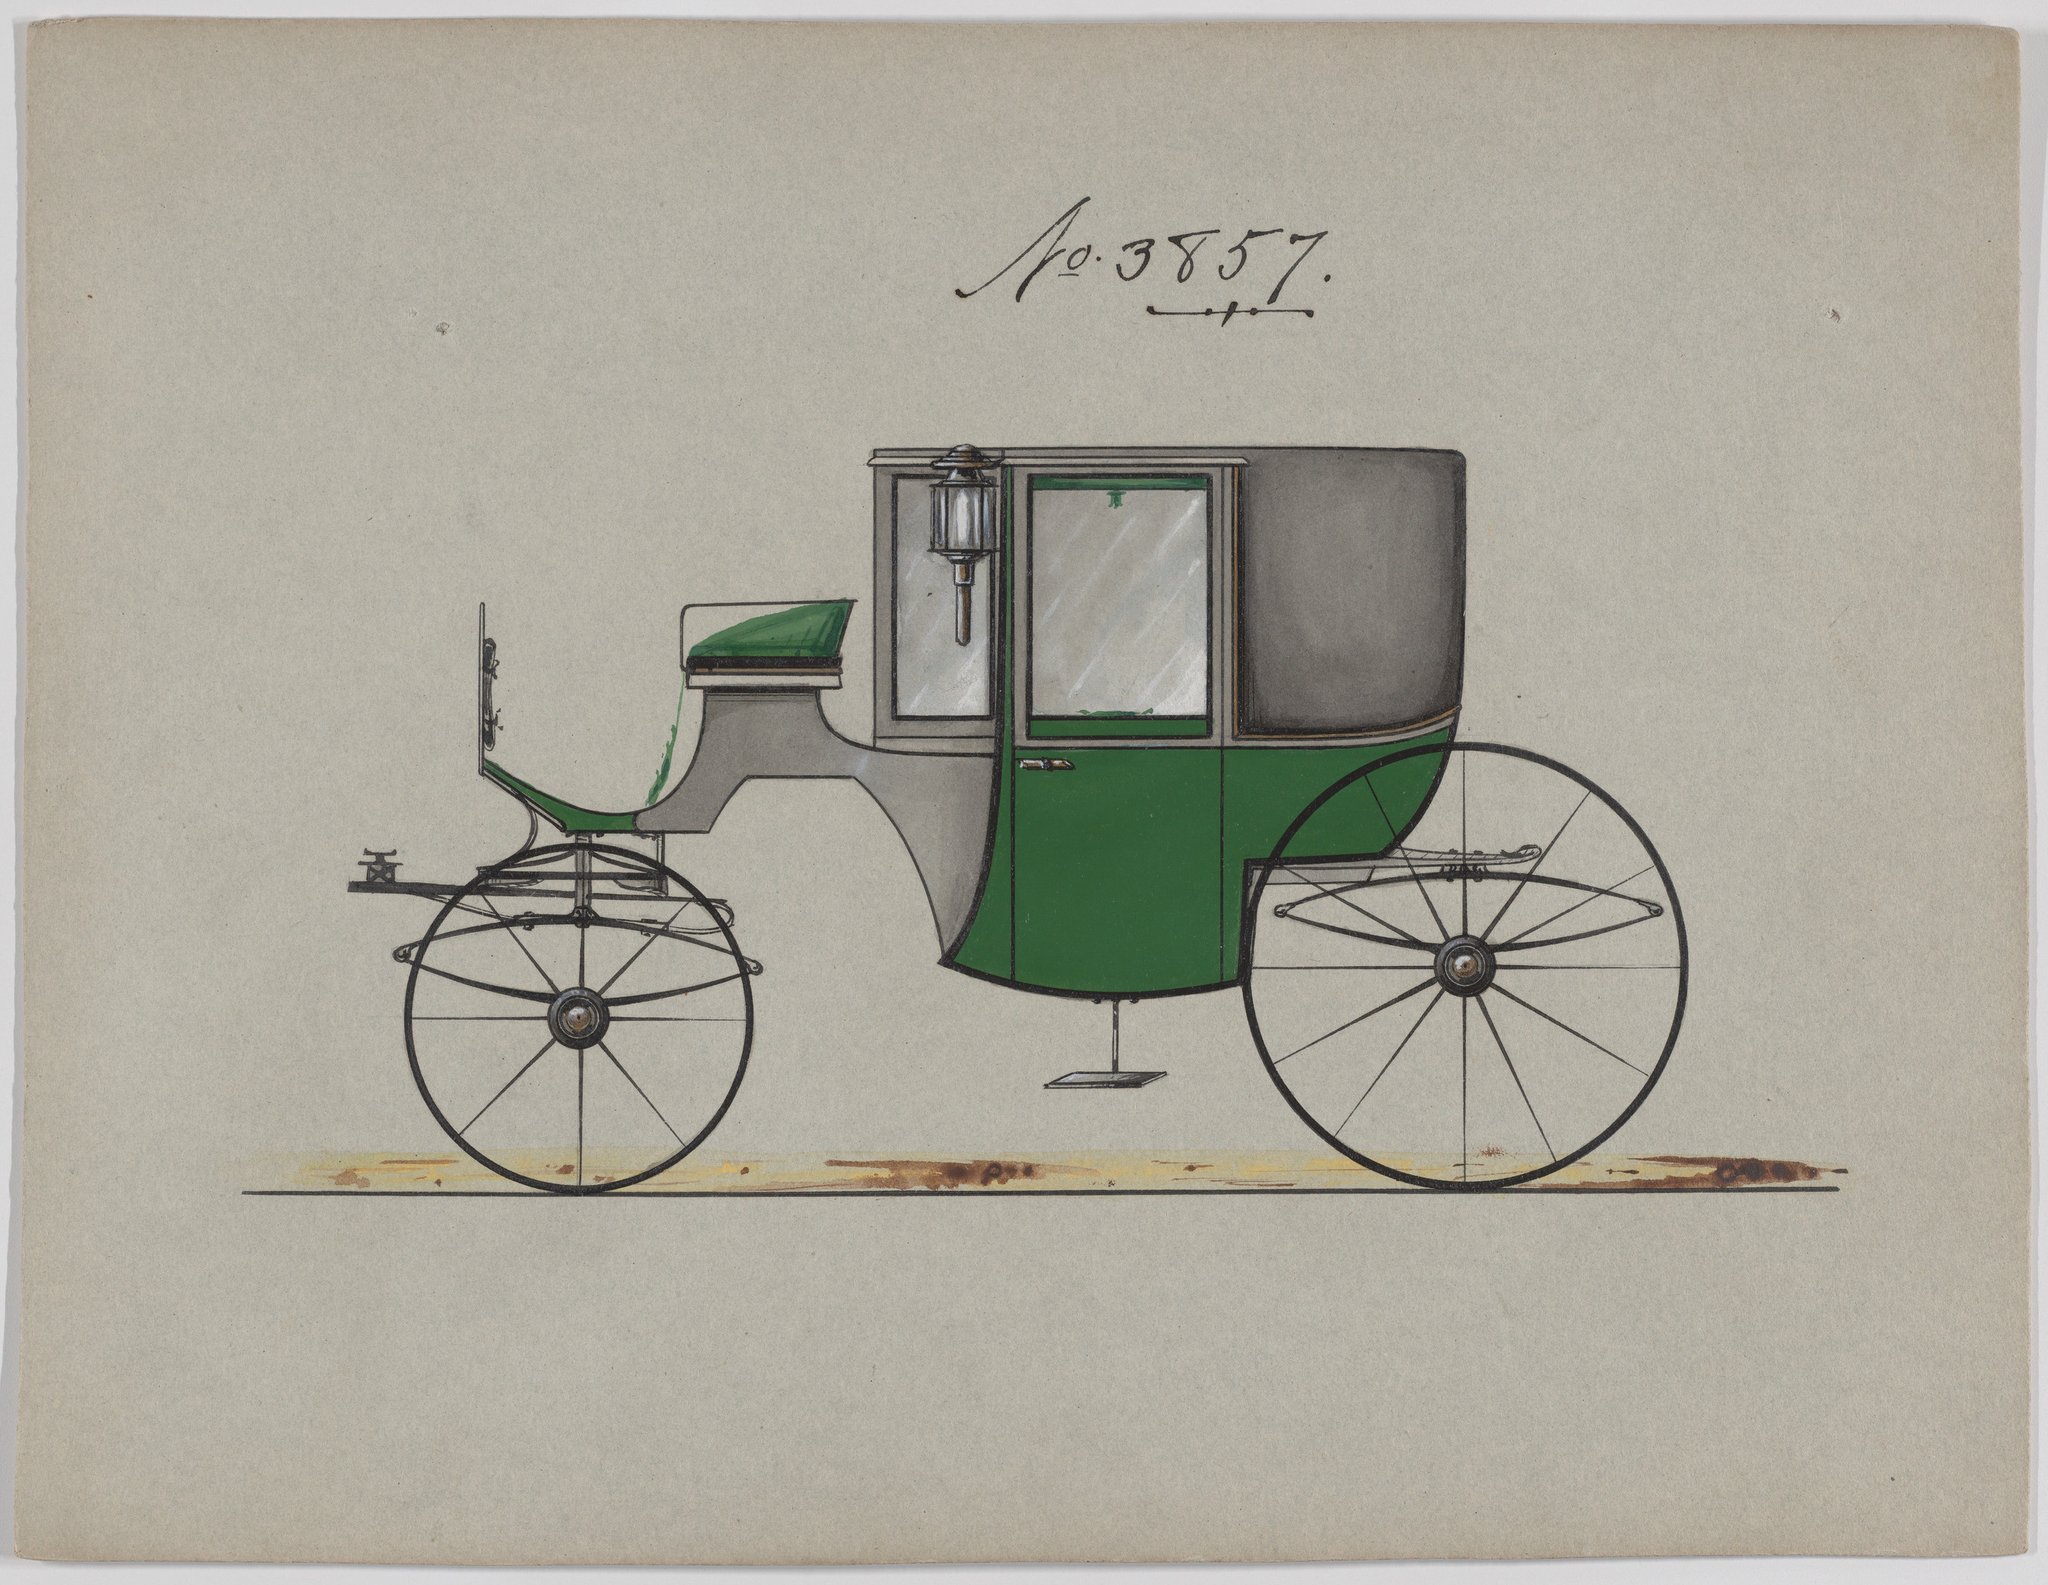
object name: drawing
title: Design for Coupé, no. 3857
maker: brewster & co.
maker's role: manufacturer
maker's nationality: american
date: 1883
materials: gouache, gum arabic, ink, watercolor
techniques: pen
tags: carriages